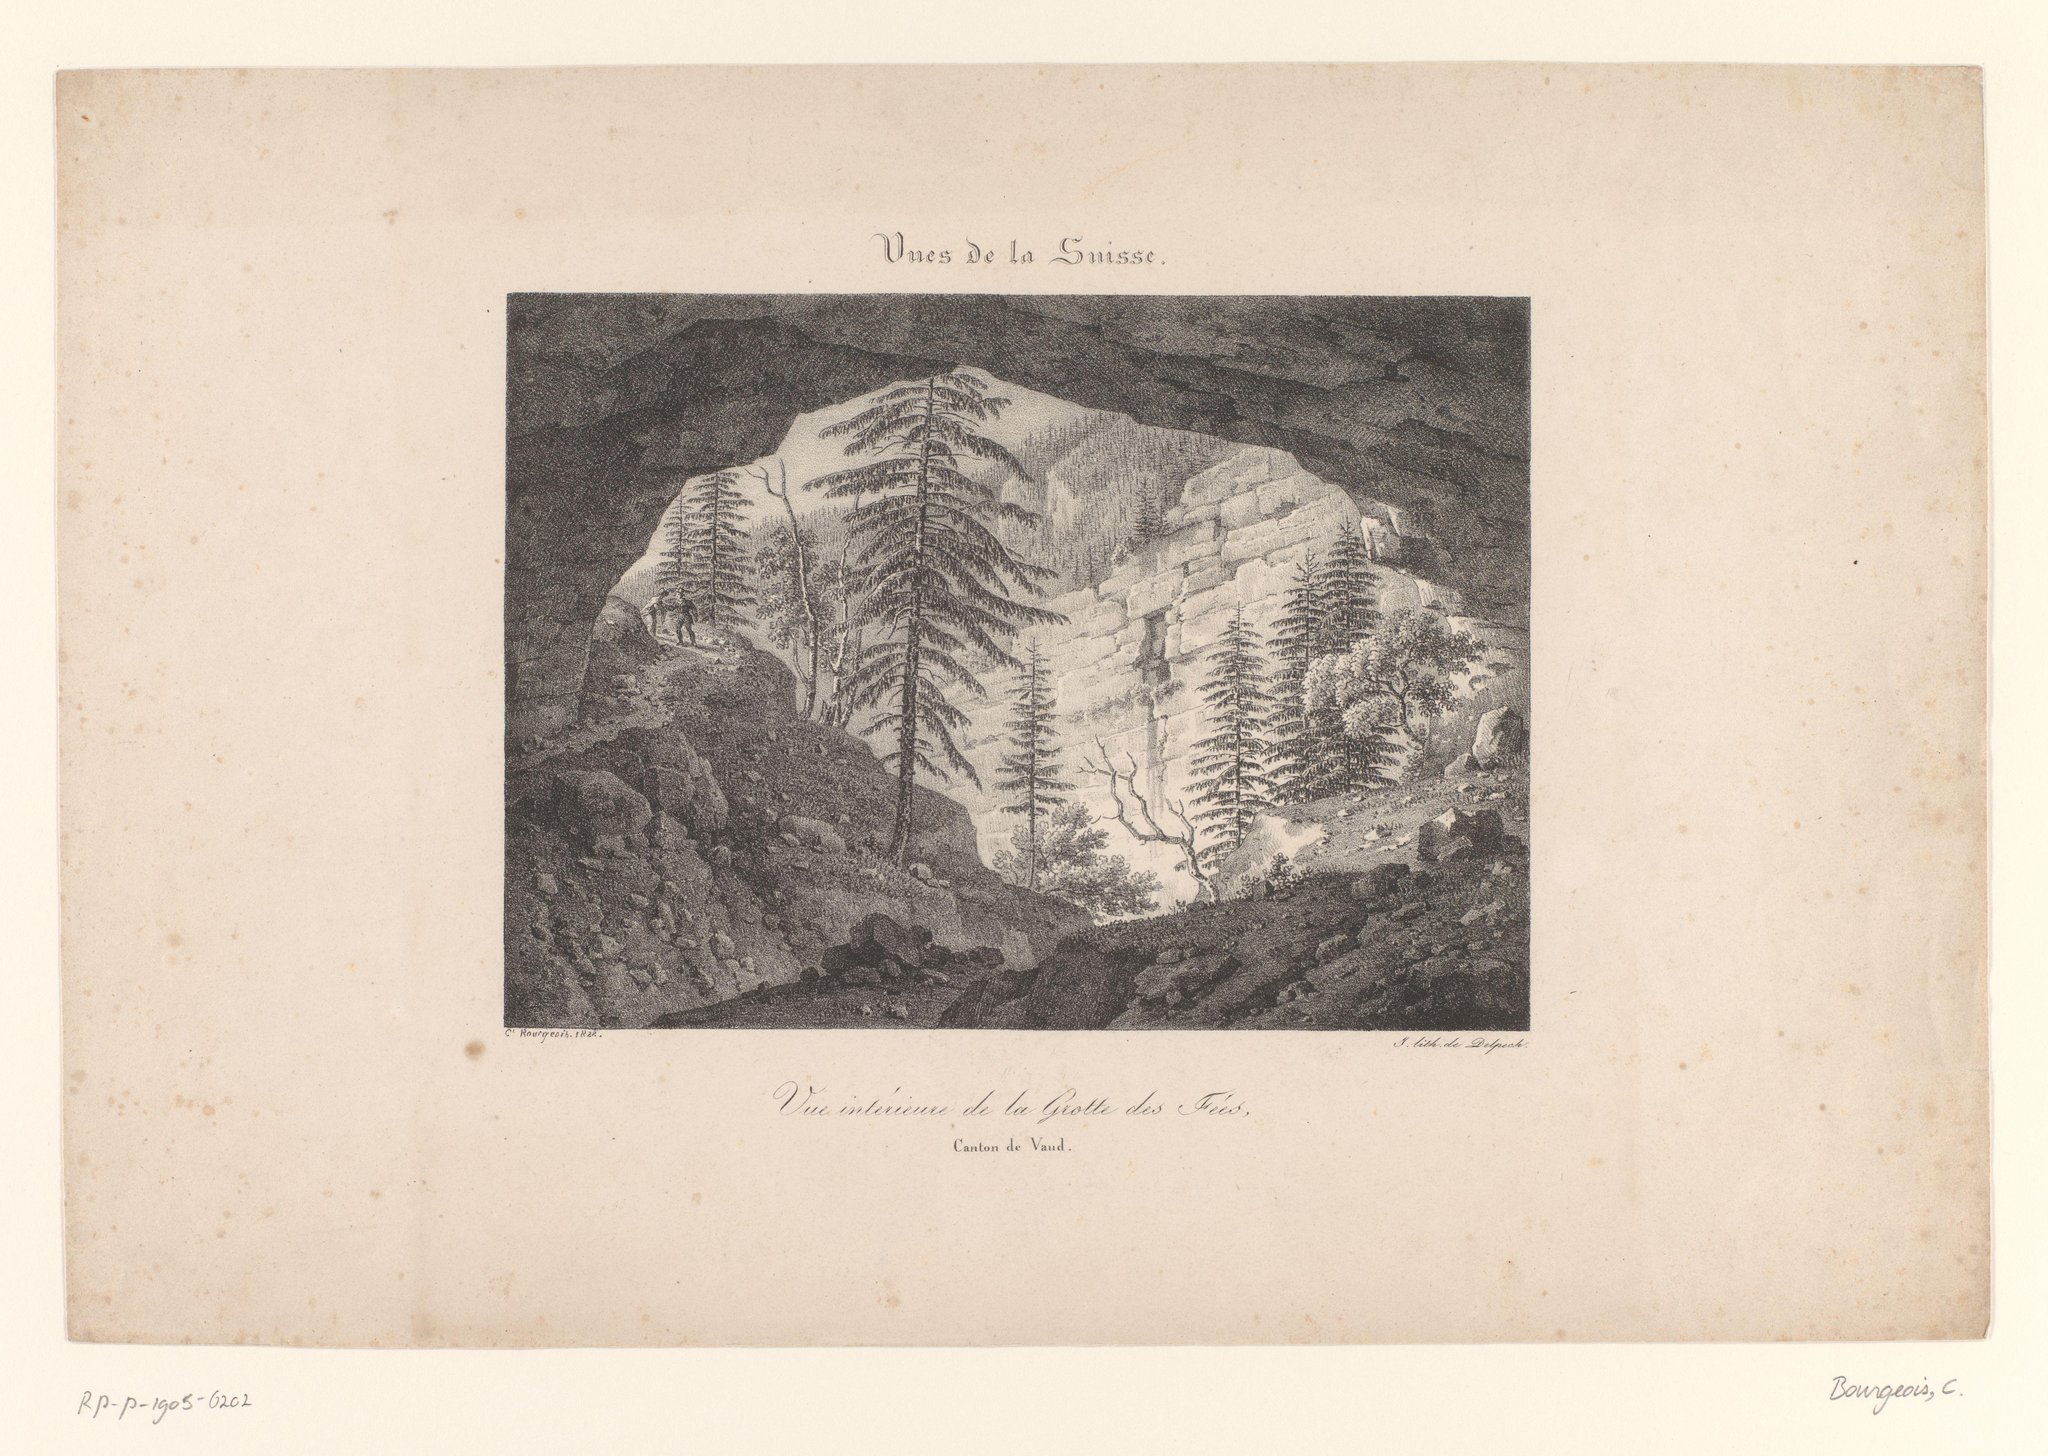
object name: print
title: Zicht vanuit de grotten van Vallorbe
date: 1822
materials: paper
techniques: lithograph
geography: paris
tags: cave, grotto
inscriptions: collector's mark: Lugt 2228a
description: De grotten van Vallorbe worden ook wel de Feeëngrotten genoemd.